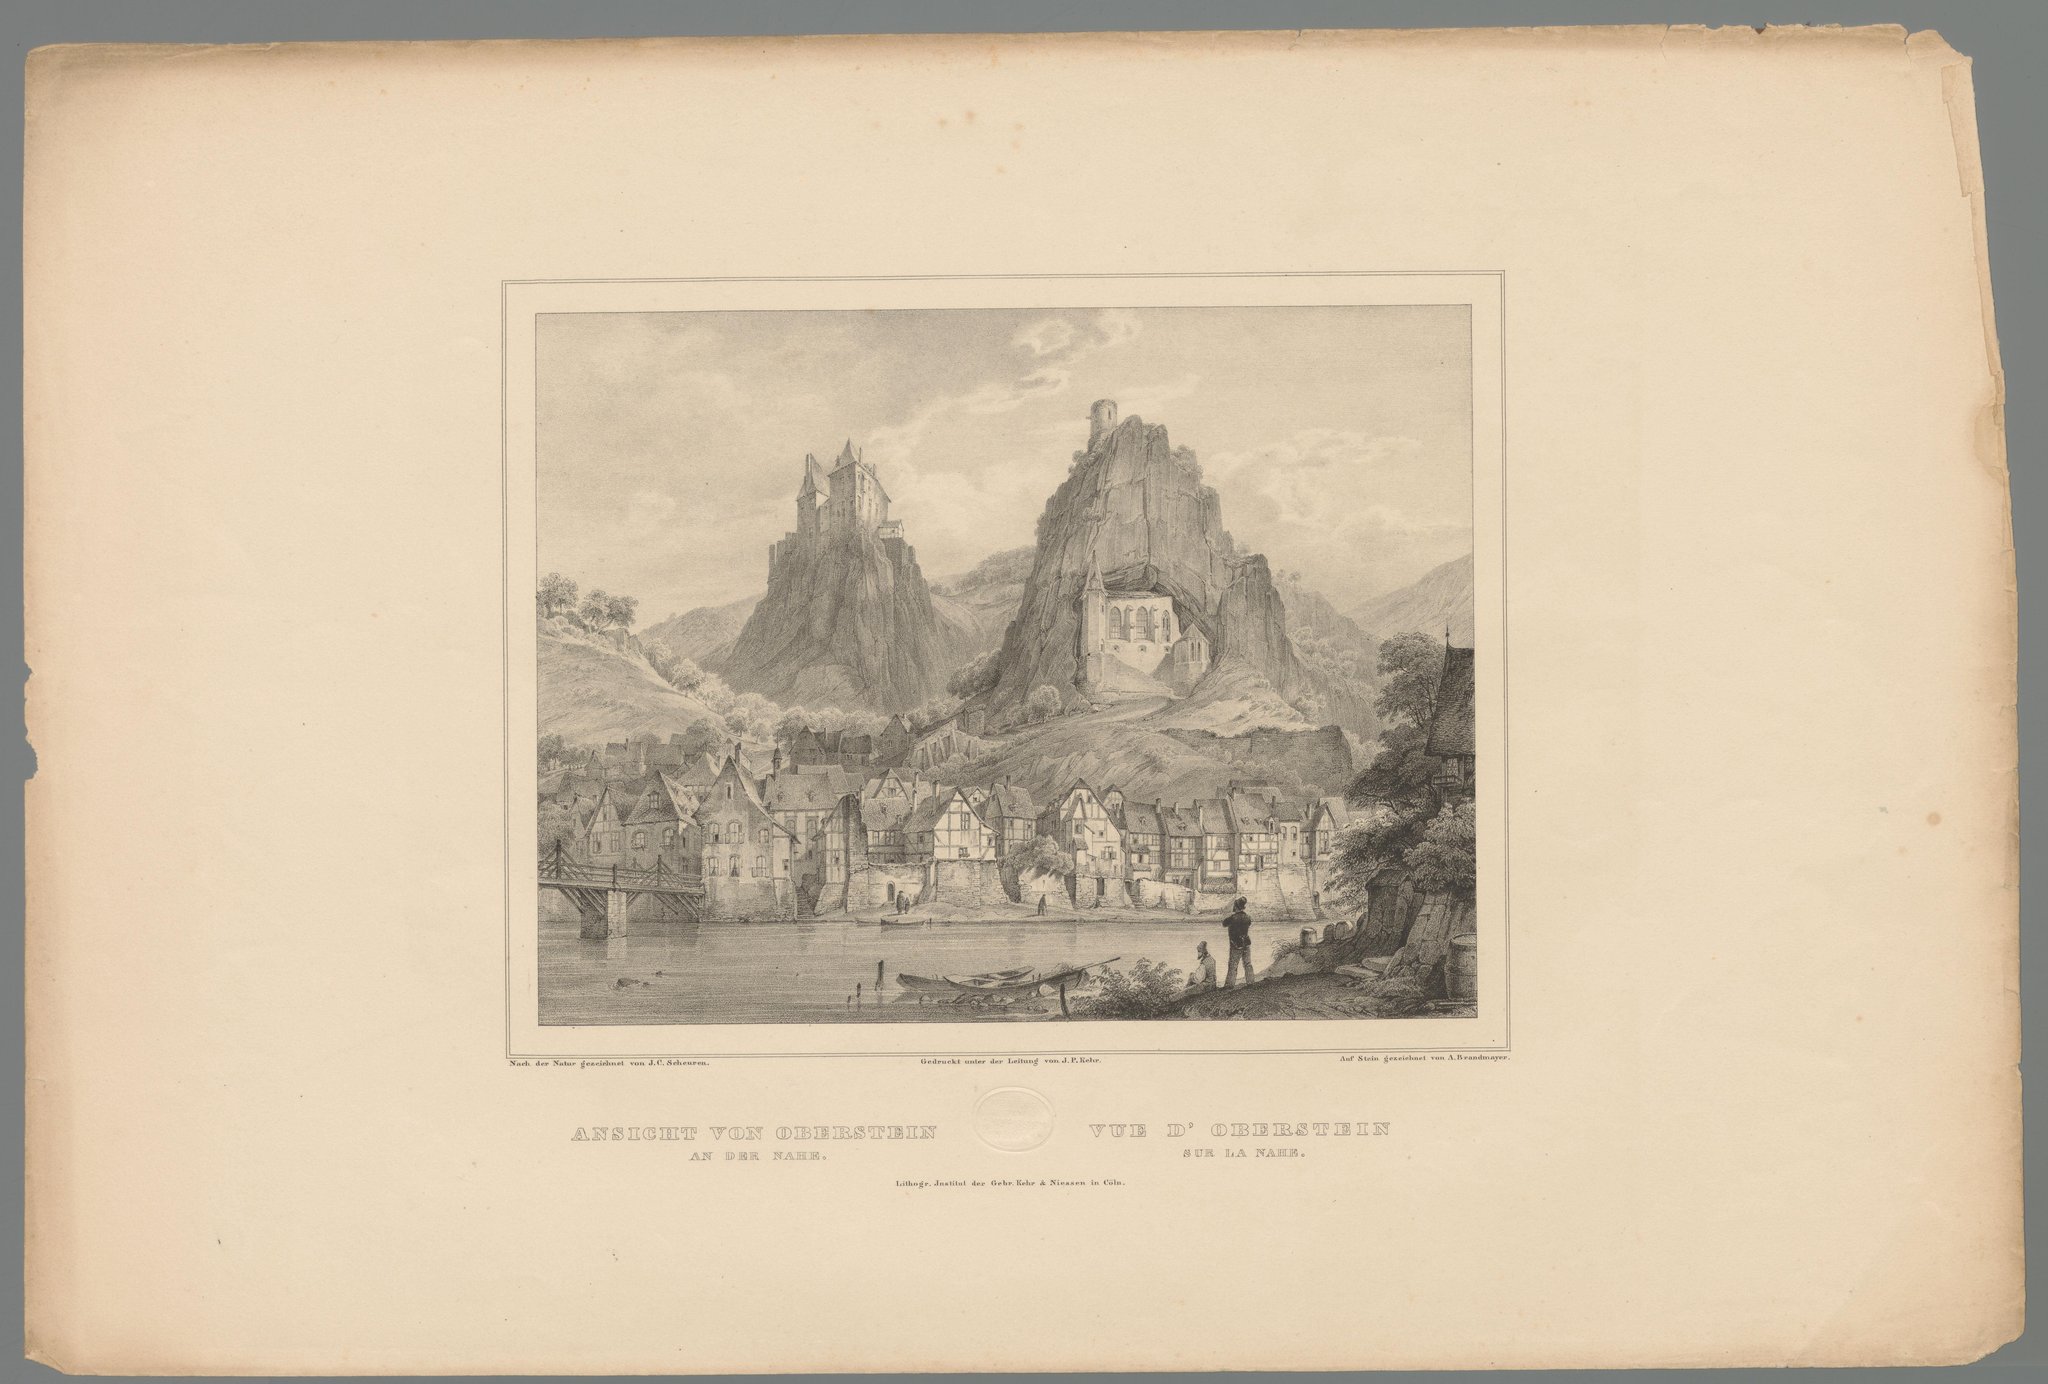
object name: print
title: Ansicht von Oberstein an der Nahe / Vue d'Oberstein sur la Nahe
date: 1834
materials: paper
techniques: lithograph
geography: cologne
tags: landscape with tower or castle, city-view, and landscape with man-made constructions (+ city(-scape) with figures, staffage), mountains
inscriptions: collector's mark: Lugt 2228, check stamp: ‘Verlag von L. Niessen in Cöln’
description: De serie 'Das Nahe-Thal. Von dem Ursprunge der Nahe bis zu ihrer Mündung in den Rhein' is uitgegeven in vijf delen van elk vier prenten vervaardigd door A. Brandmayer en Andreas Borum. Tien prenten uit deze serie zijn daarnaast waarschijnlijk ook nog samen onder de titel 'Kreuznach und seine Umgebung. Erinnerung an seine Heilquellen und das Nahe-Thal' uitgegeven.